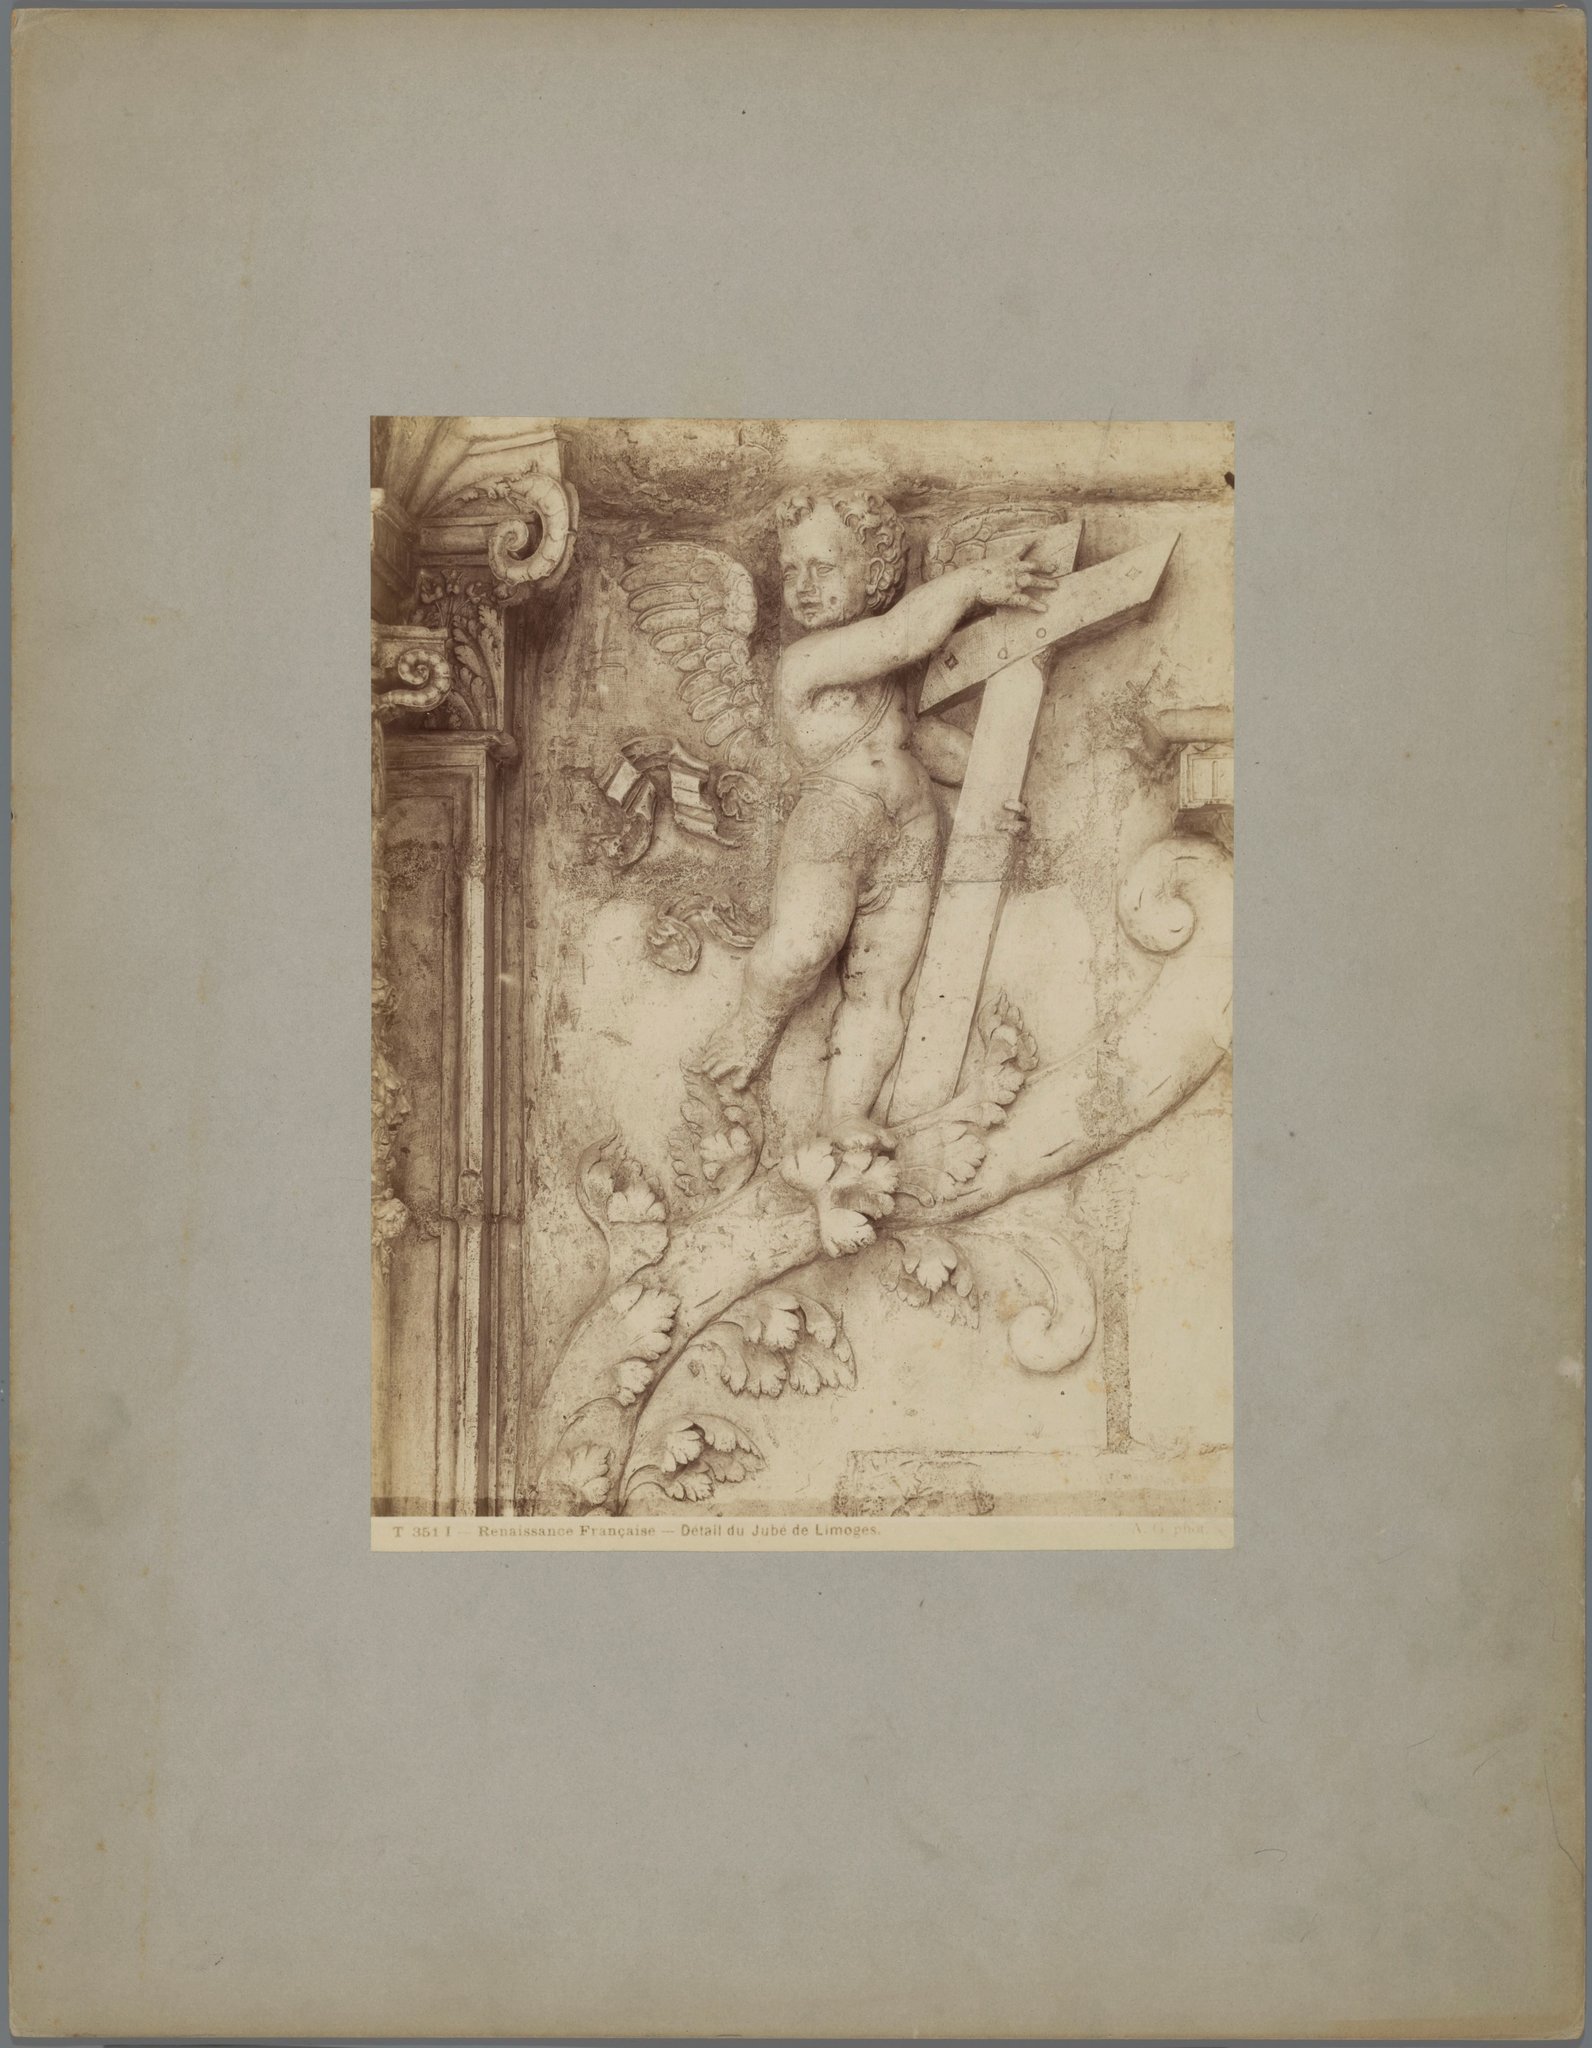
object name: photograph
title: Renaissance Française - Figures décorant une arcade, par Jean Goujon, - Hôtel Carnavalet.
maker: adolphe giraudon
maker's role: publisher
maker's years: 1849-1929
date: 1875-1900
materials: cardboard, photographic support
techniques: albumen print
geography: europe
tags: other architectural details (with name), sculpture (+ relief ~ sculpture), europe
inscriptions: name: ‘A. GIRAUDON EDITEUR 15. R [...] PARIS’, number: ‘T 407’, collector's mark: Lugt 3937